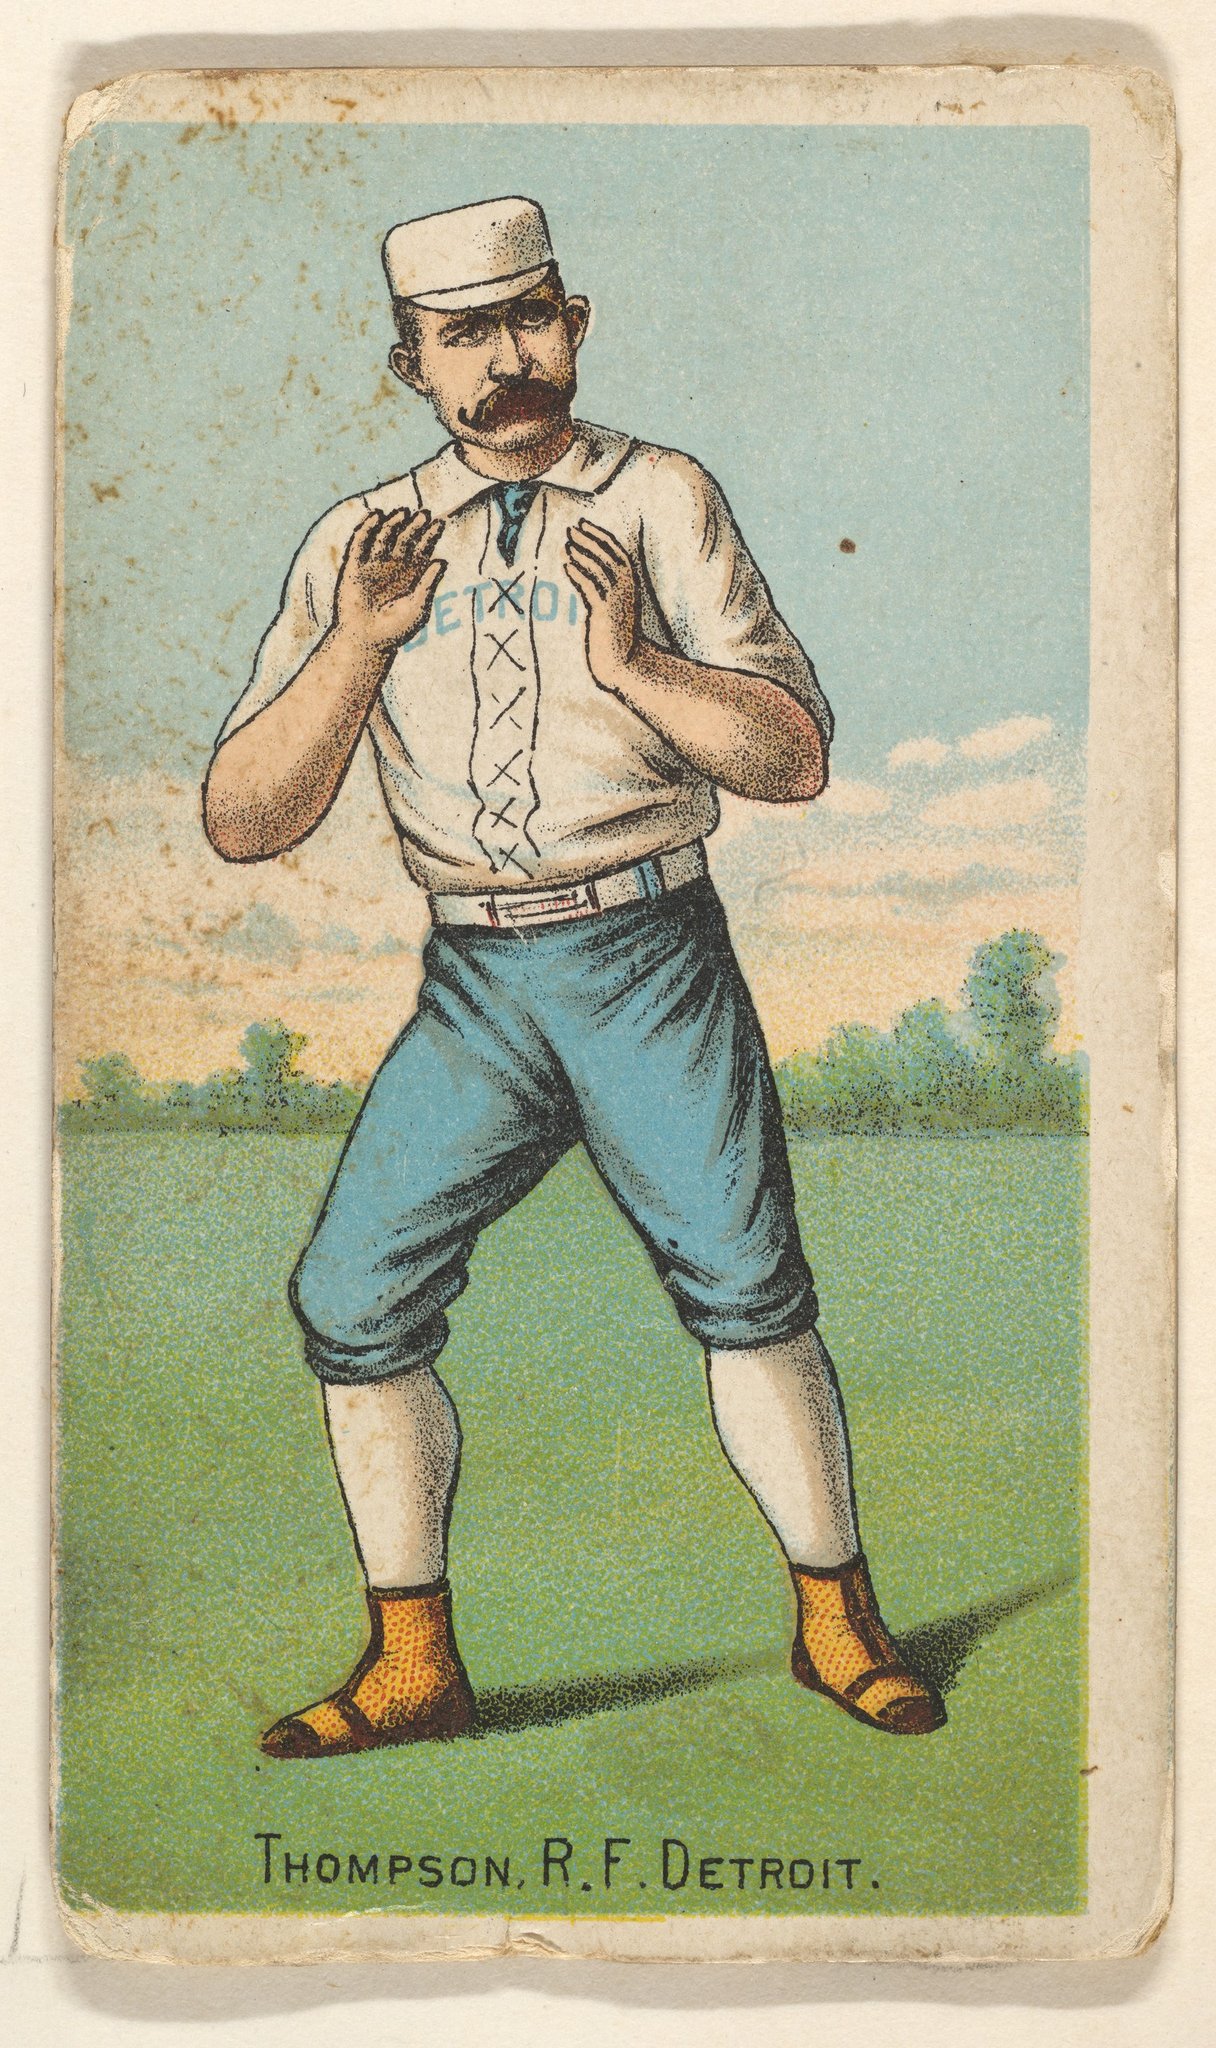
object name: baseball card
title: Thompson, R. F., Detroit, from the Gold Coin series (N284) for Gold Coin Chewing Tobacco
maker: d. buchner & co., new york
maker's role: publisher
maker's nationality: american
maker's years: 1850-1900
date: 1887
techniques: color lithograph, drawing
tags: men,baseball,athletes